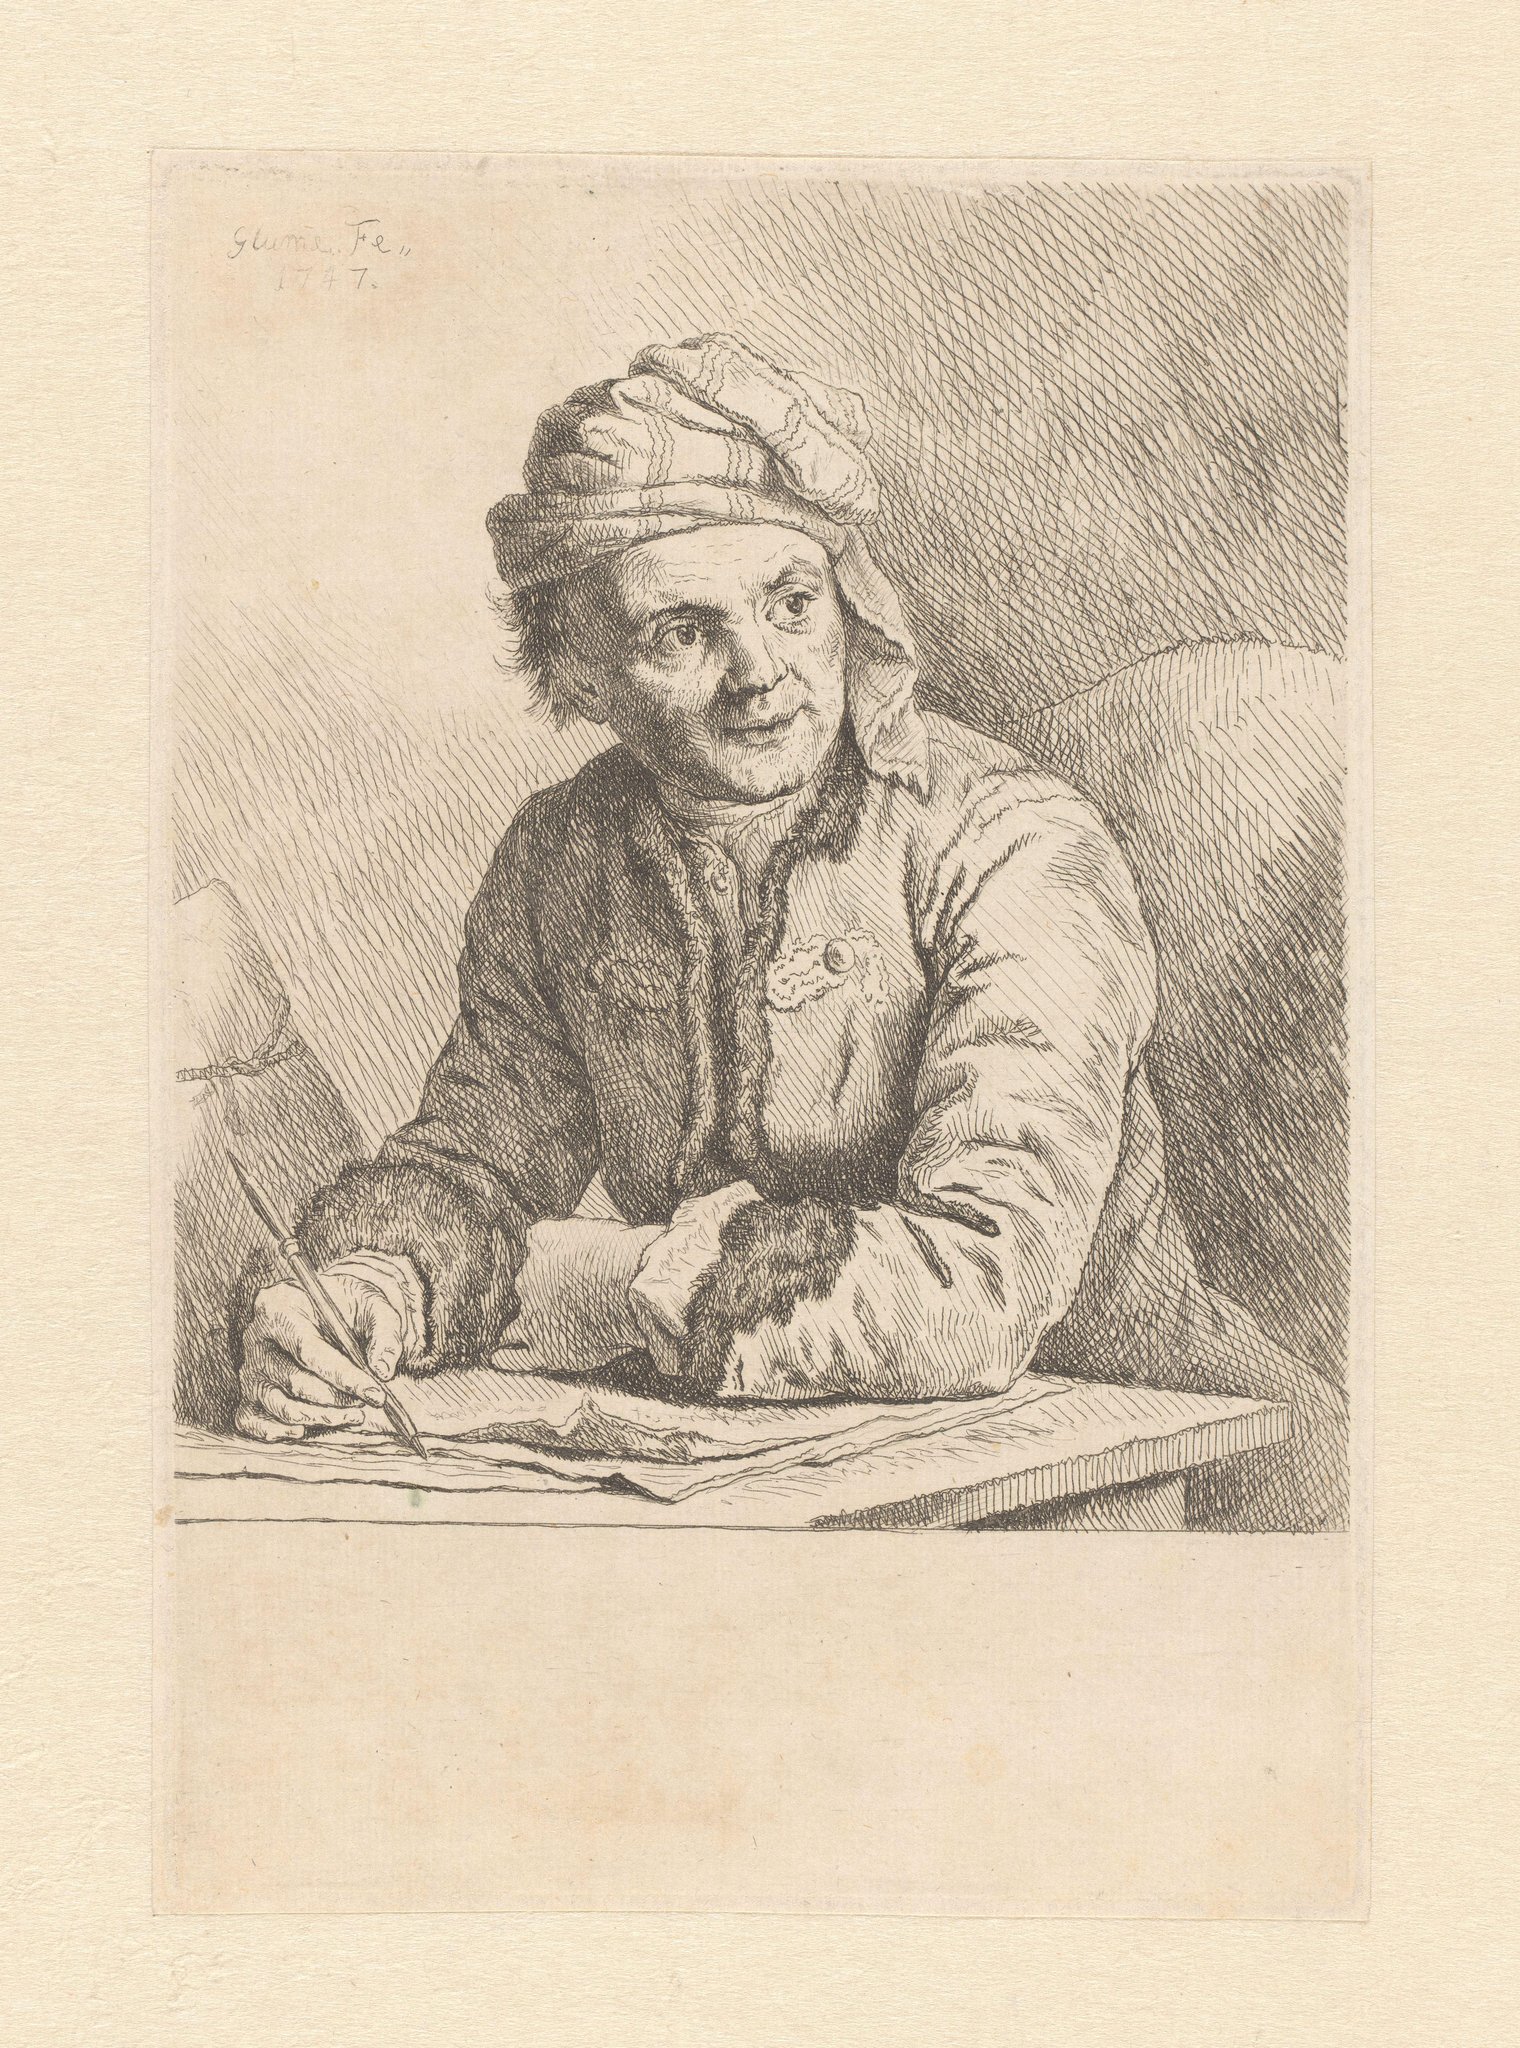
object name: print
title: Portret van de schilder en etser Joachim Martin Falbe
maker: johann gottlieb glume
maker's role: print maker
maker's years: 1711-1778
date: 1747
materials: paper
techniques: etching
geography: berlin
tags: berlin, print maker, joachim martin falbe, historical persons, portrait, self-portrait of artist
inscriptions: collector's mark: Lugt 2228, collector's mark: Lugt 2760, inscription: ‘C. Neumann’